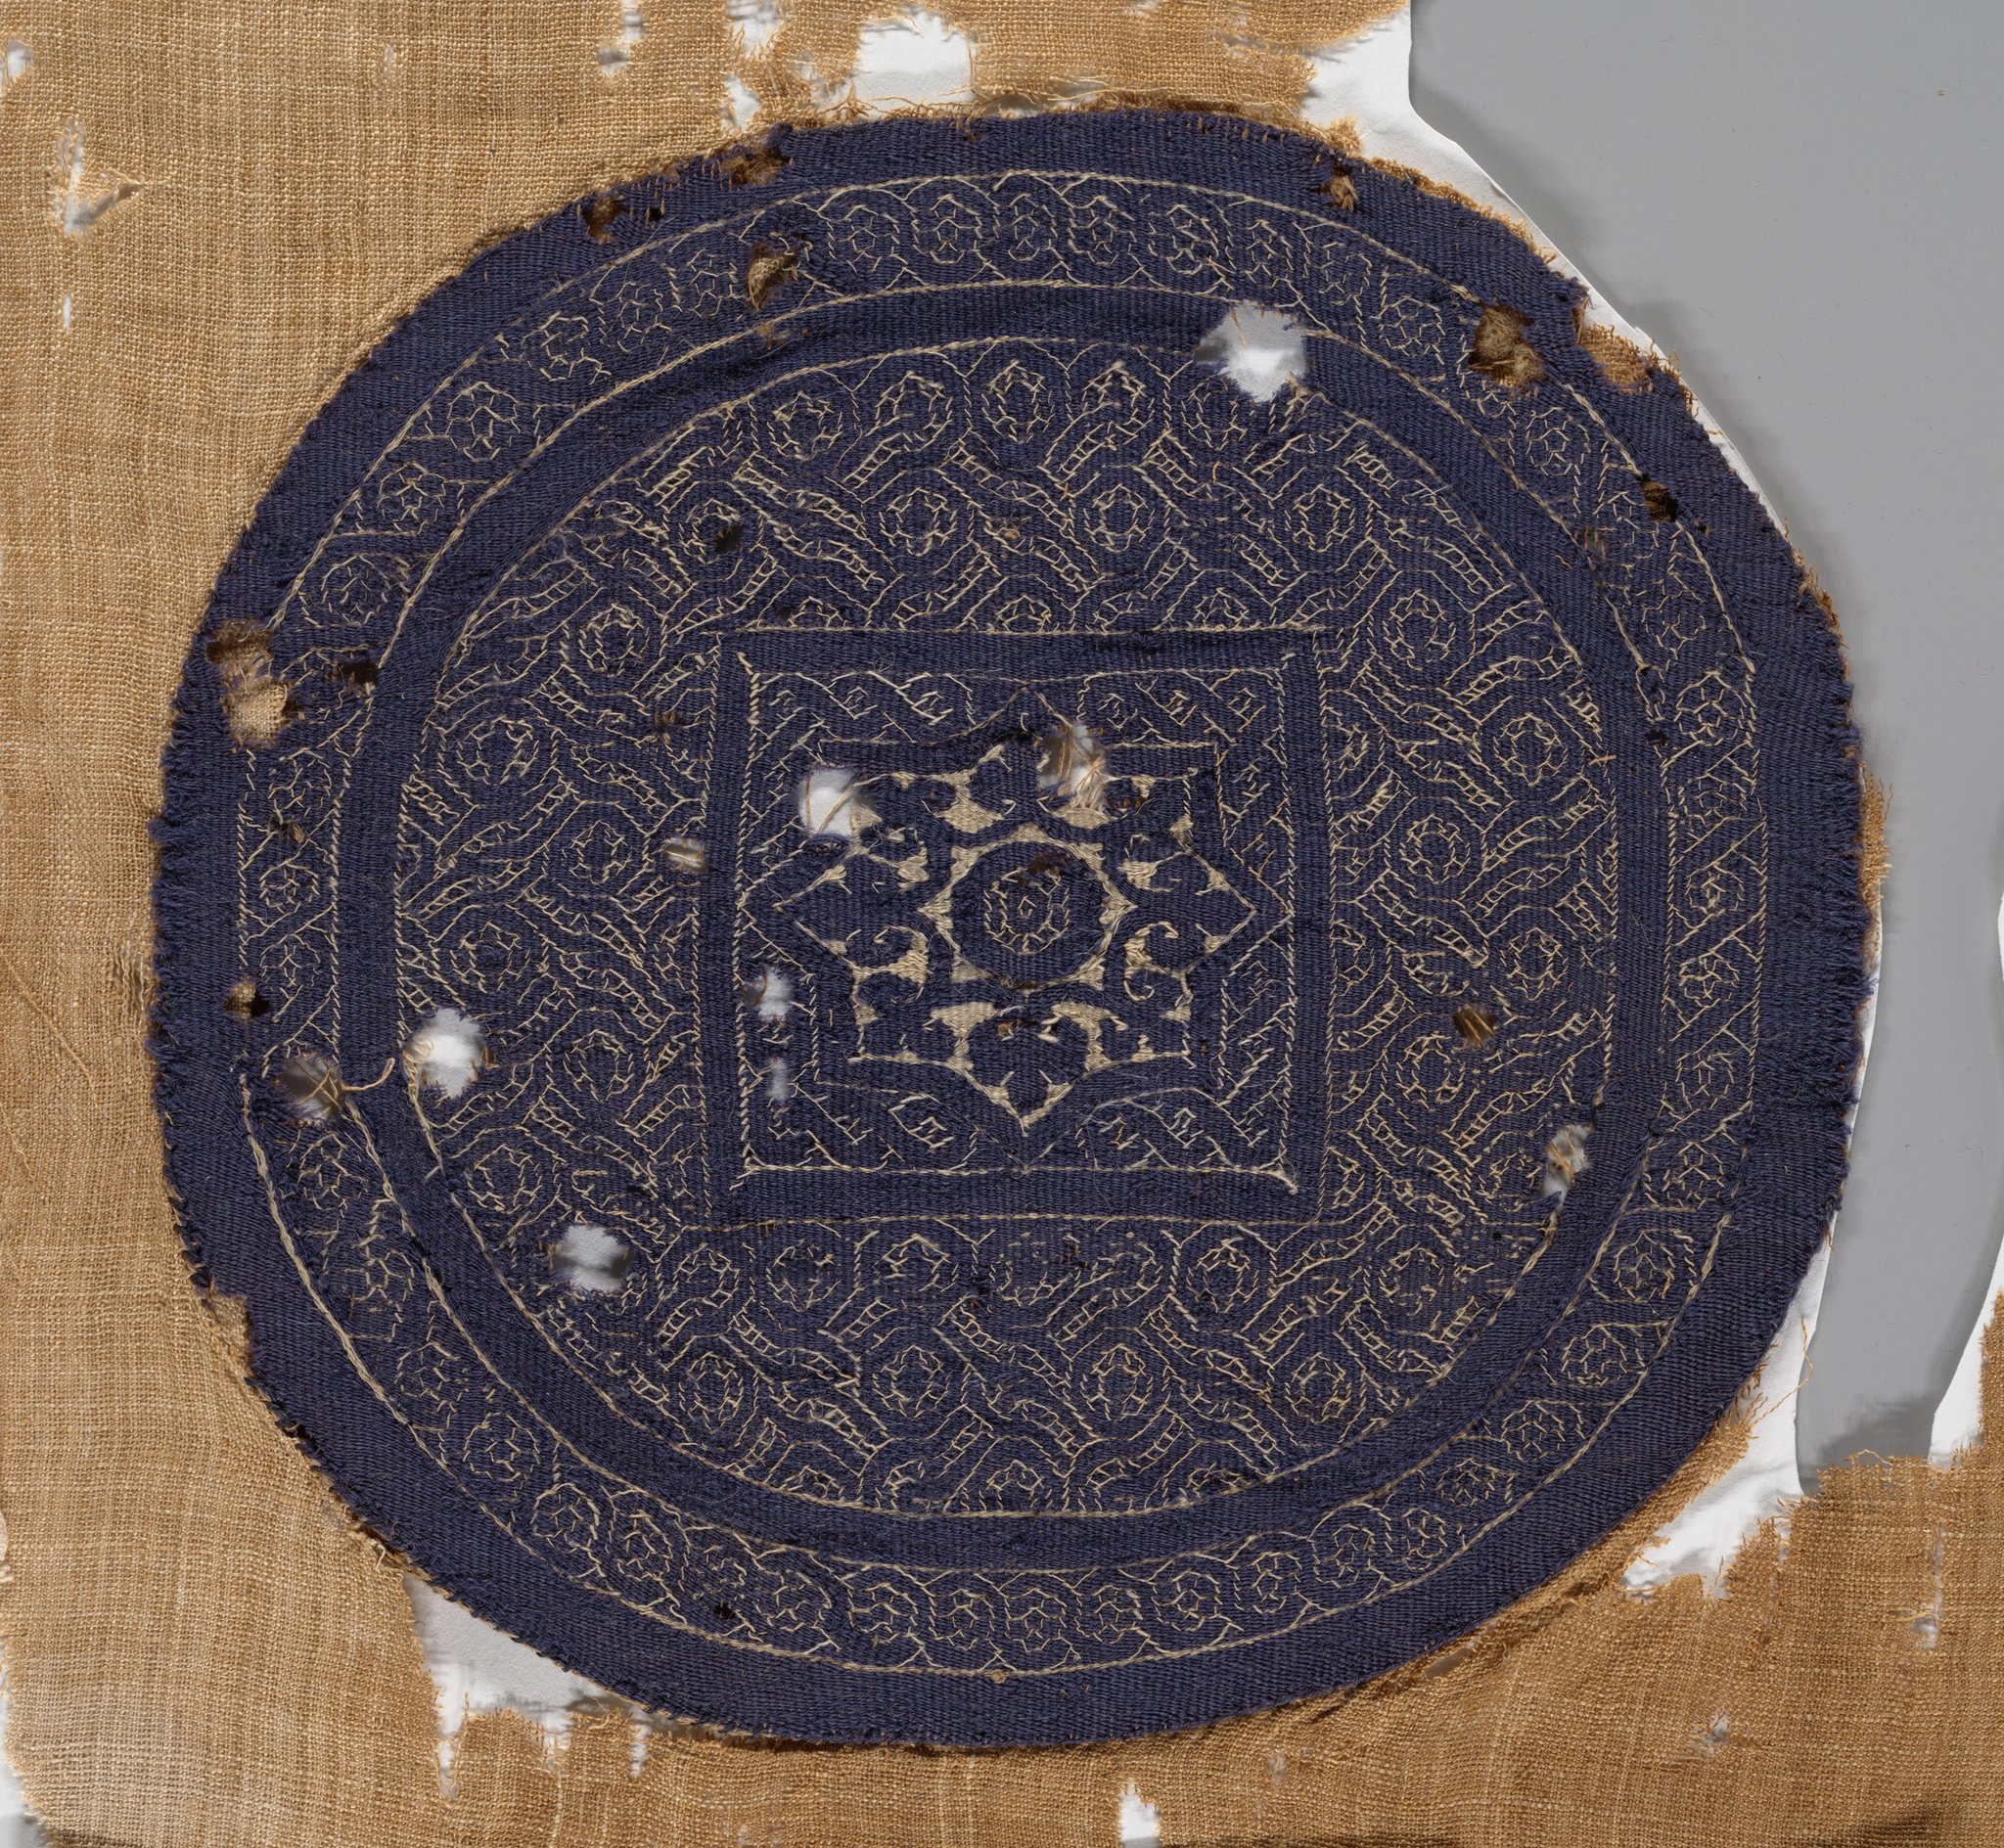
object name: textile fragment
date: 201-400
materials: linen, wool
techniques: weave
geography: egypt